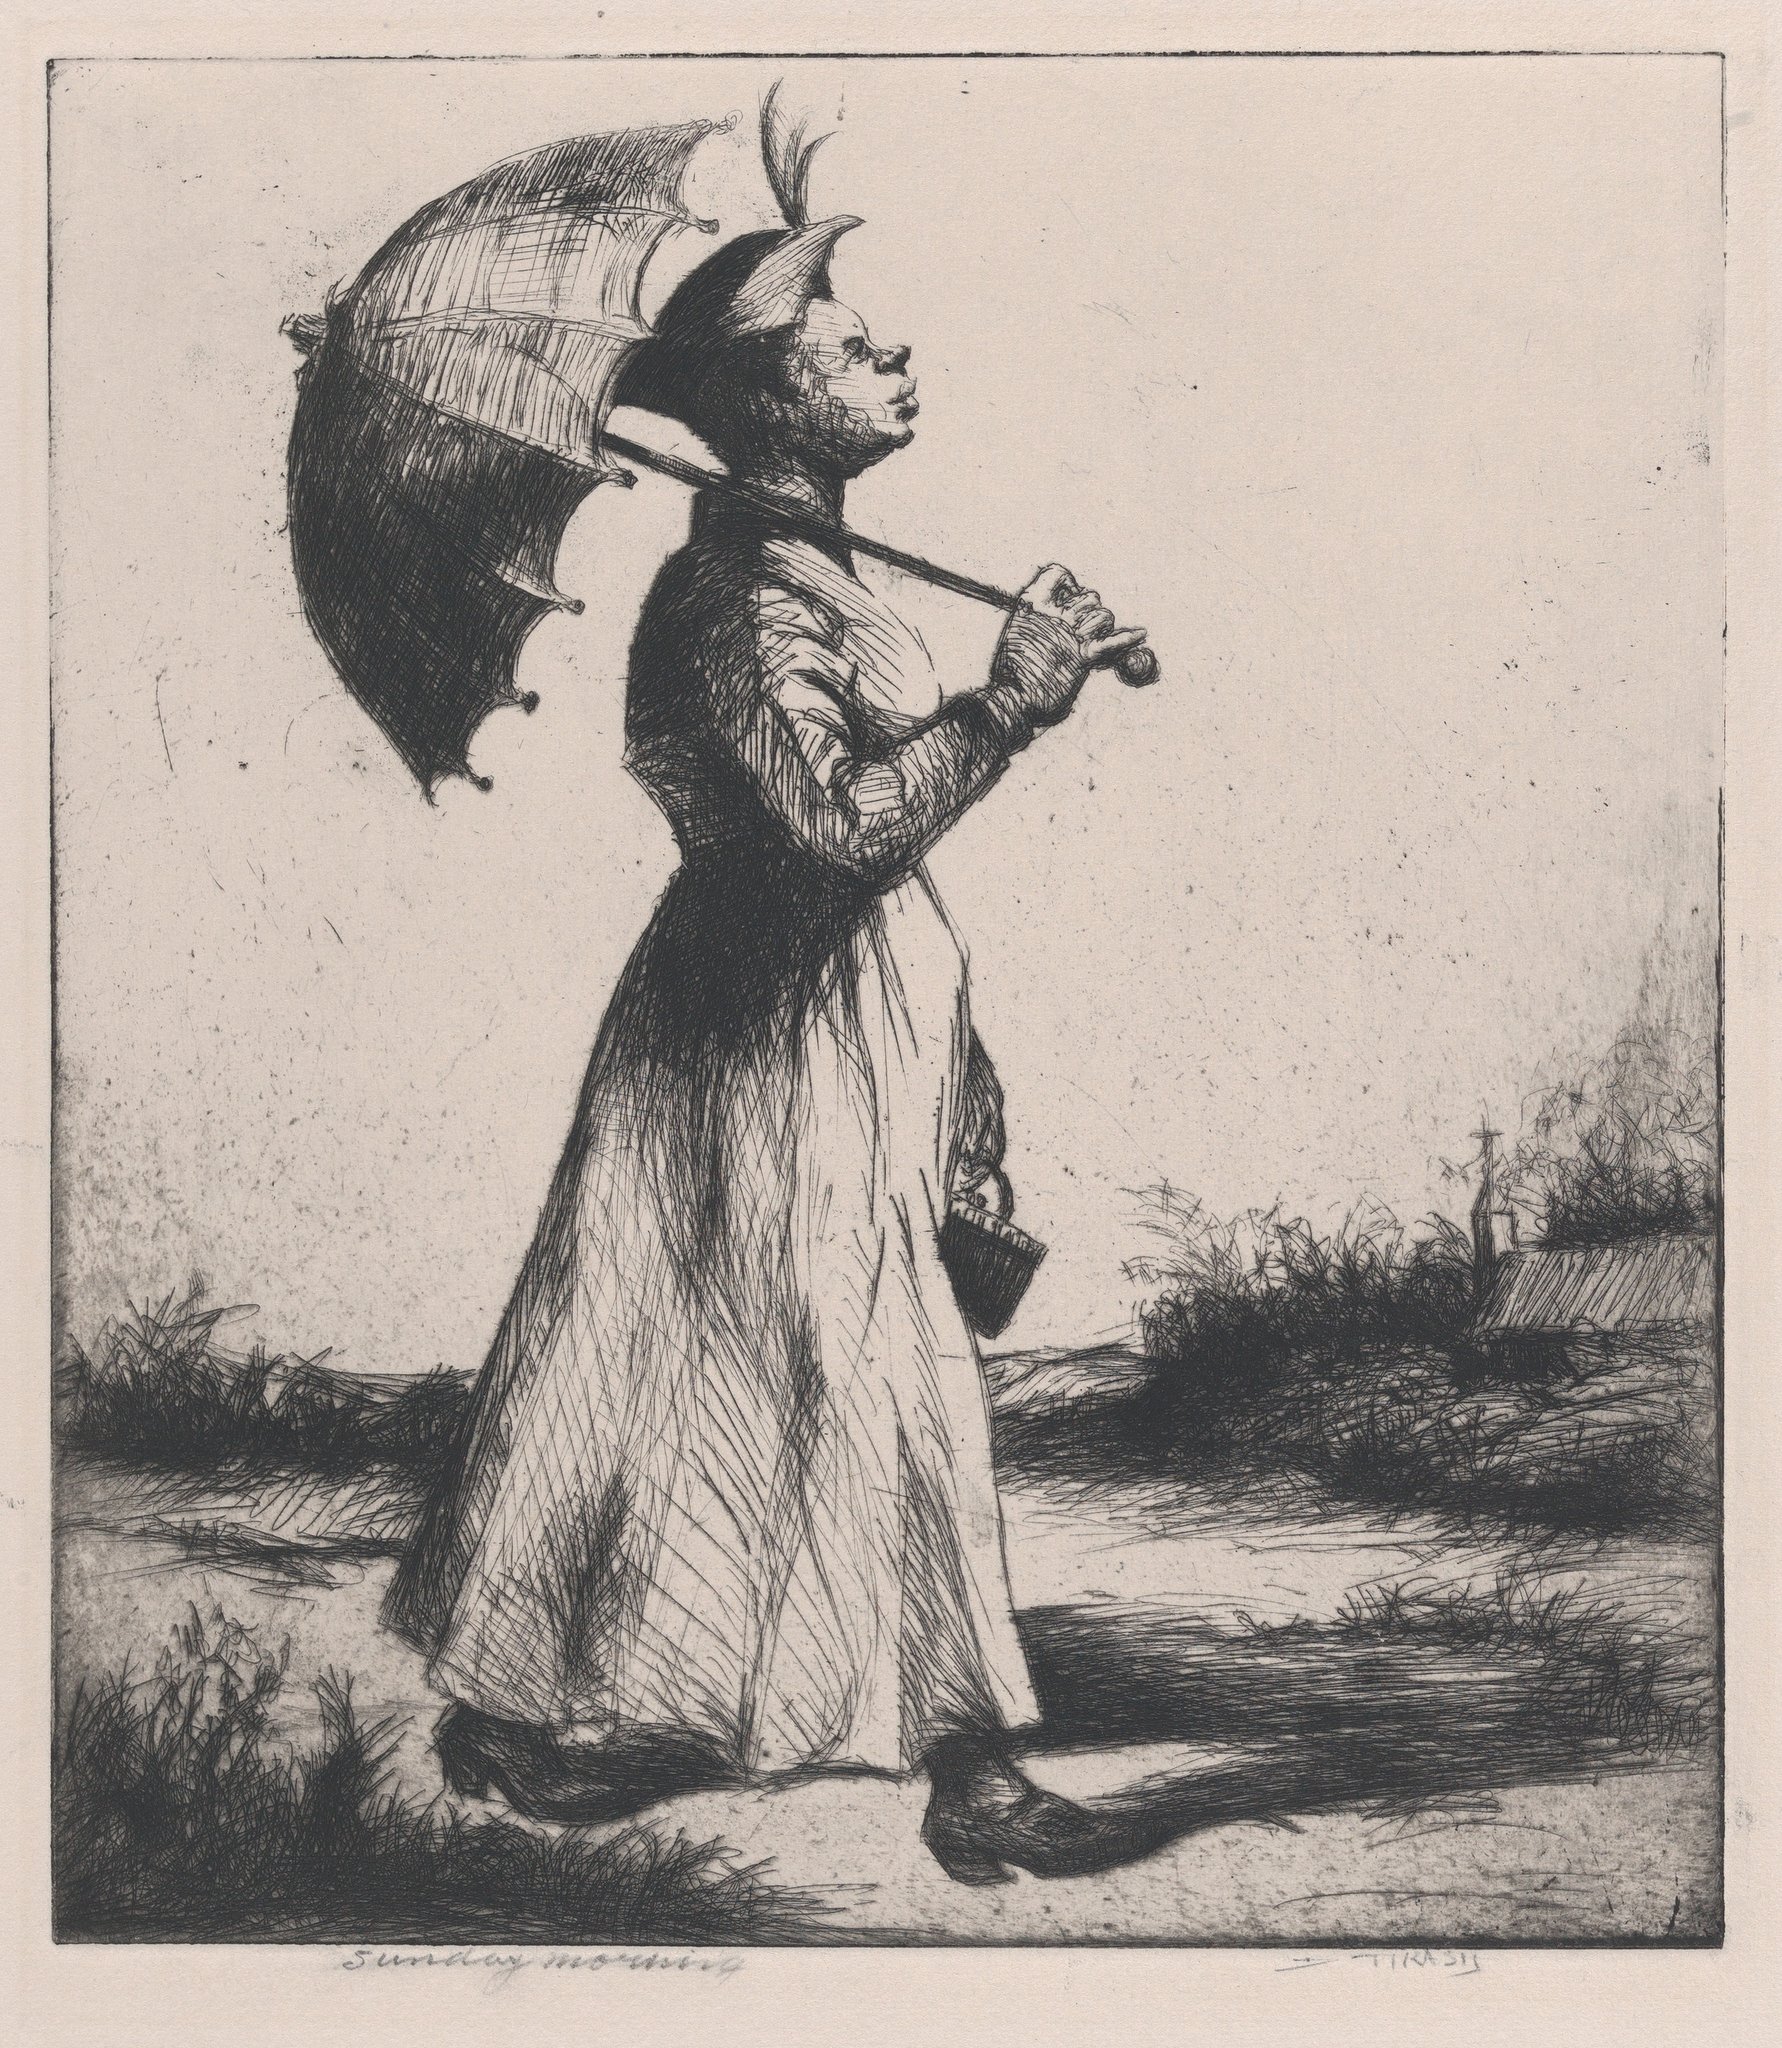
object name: print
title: Sunday Morning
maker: dox thrash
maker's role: artist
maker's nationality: american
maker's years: 1893-1965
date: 1939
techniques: drypoint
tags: women,umbrellas